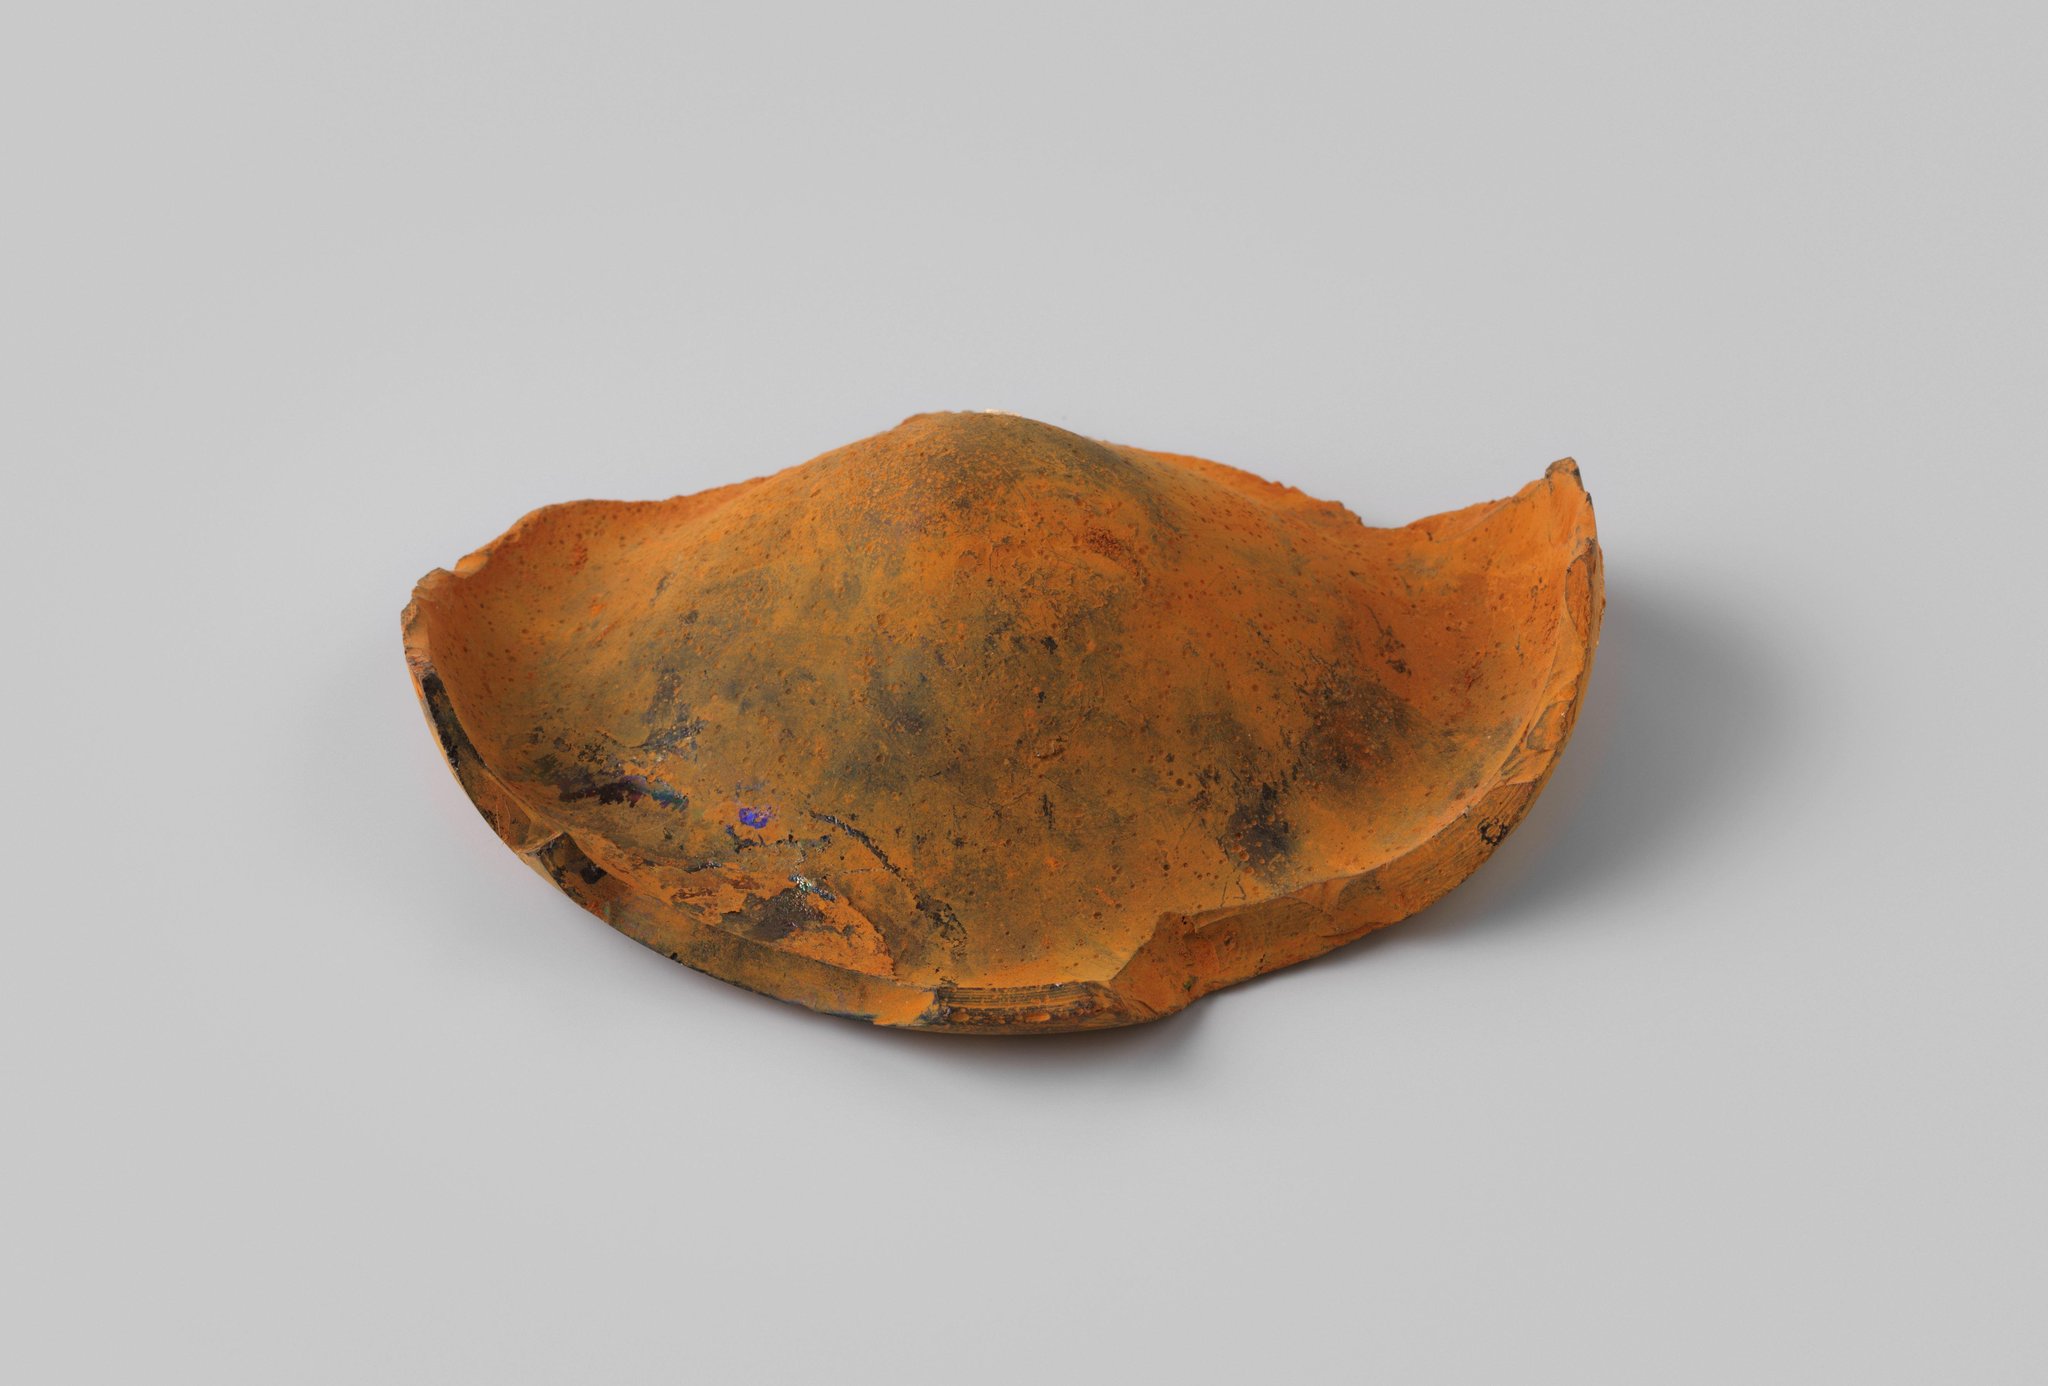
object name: sherd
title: Bodemfragment wijnfles uit het wrak van de Oost-Indiëvaarder Hollandia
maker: Anonymous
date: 1700-1743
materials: glass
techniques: green glass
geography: netherlands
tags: verenigde oostindische compagnie, hollandia (schip), annet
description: Onion-shaped bottle or bottle with vertical side, base, cs-kick-up. Continental production.